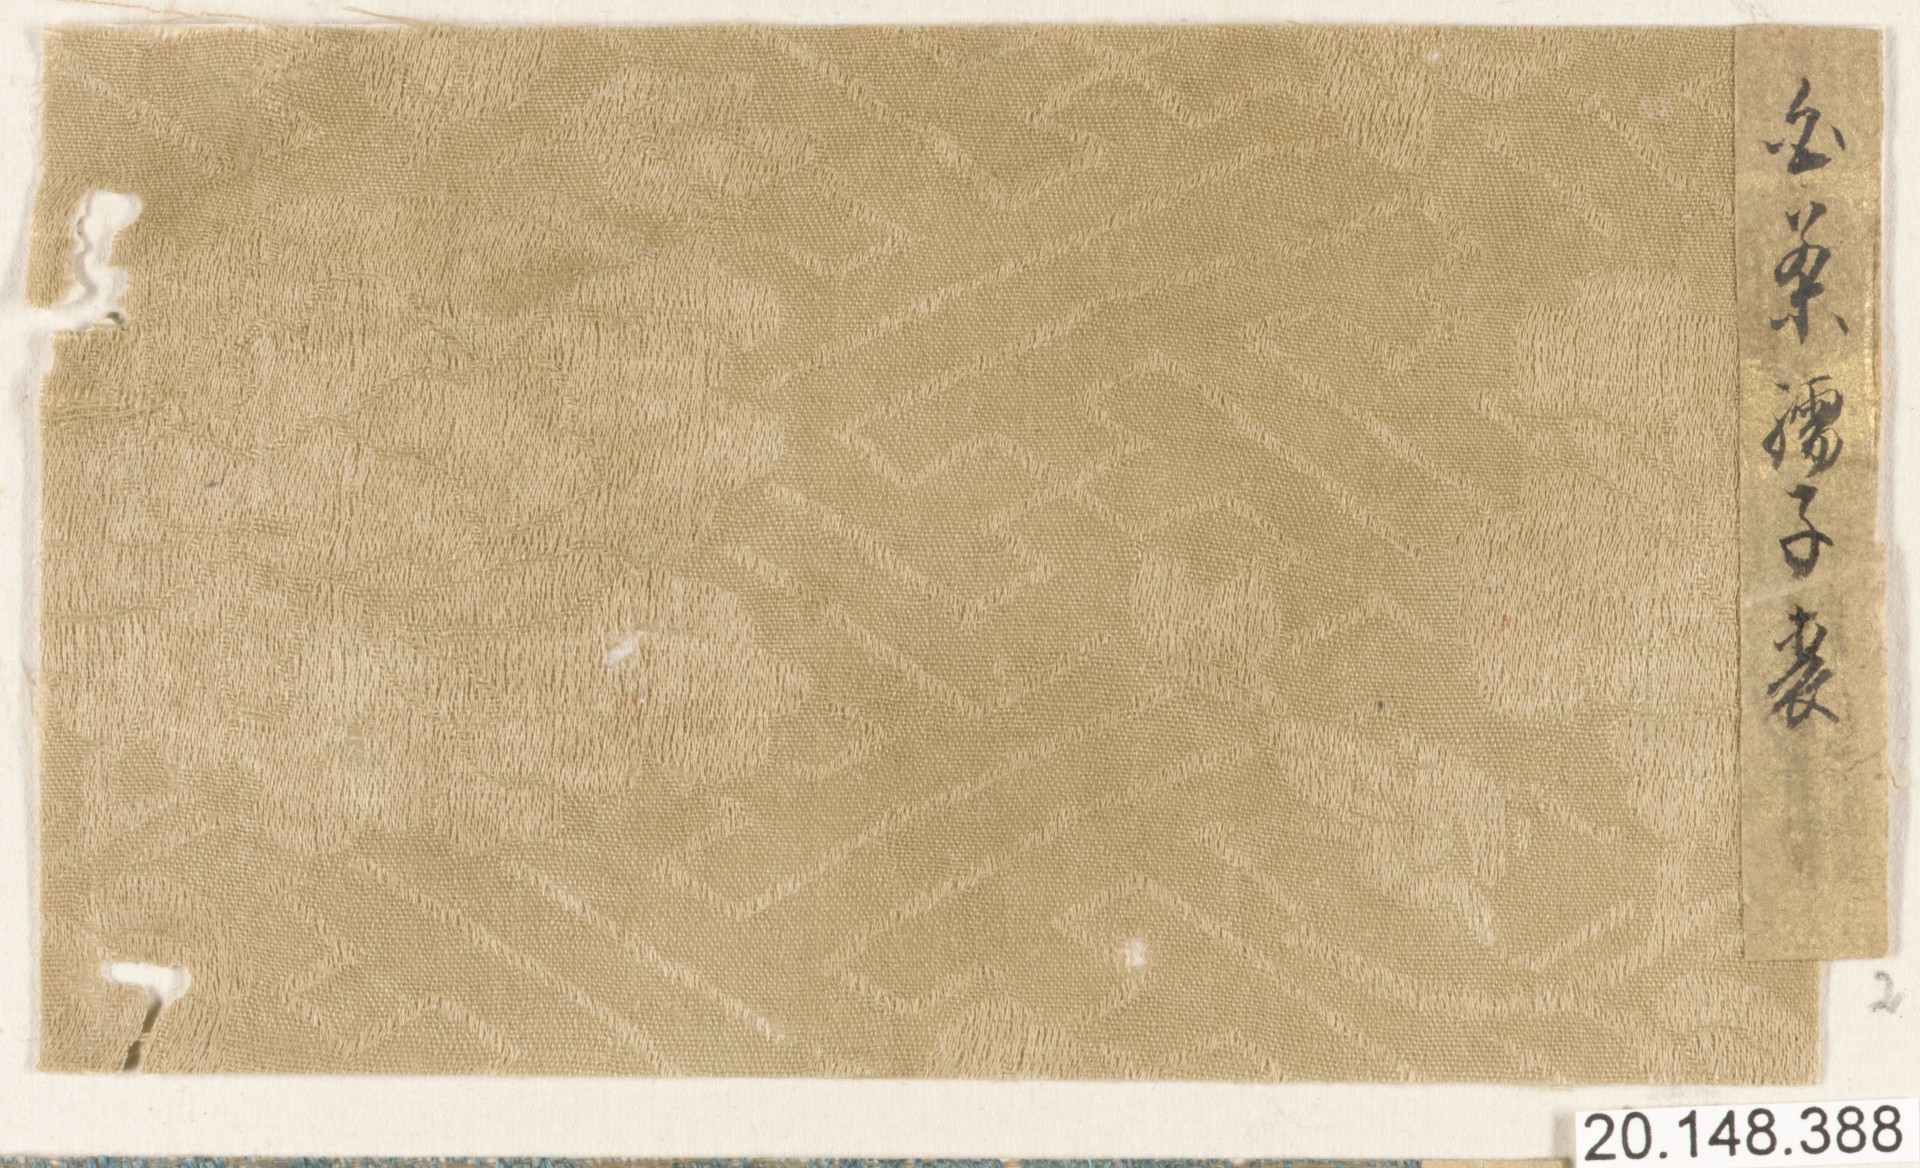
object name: piece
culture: japanese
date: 1601-1700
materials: silk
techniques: compound weave